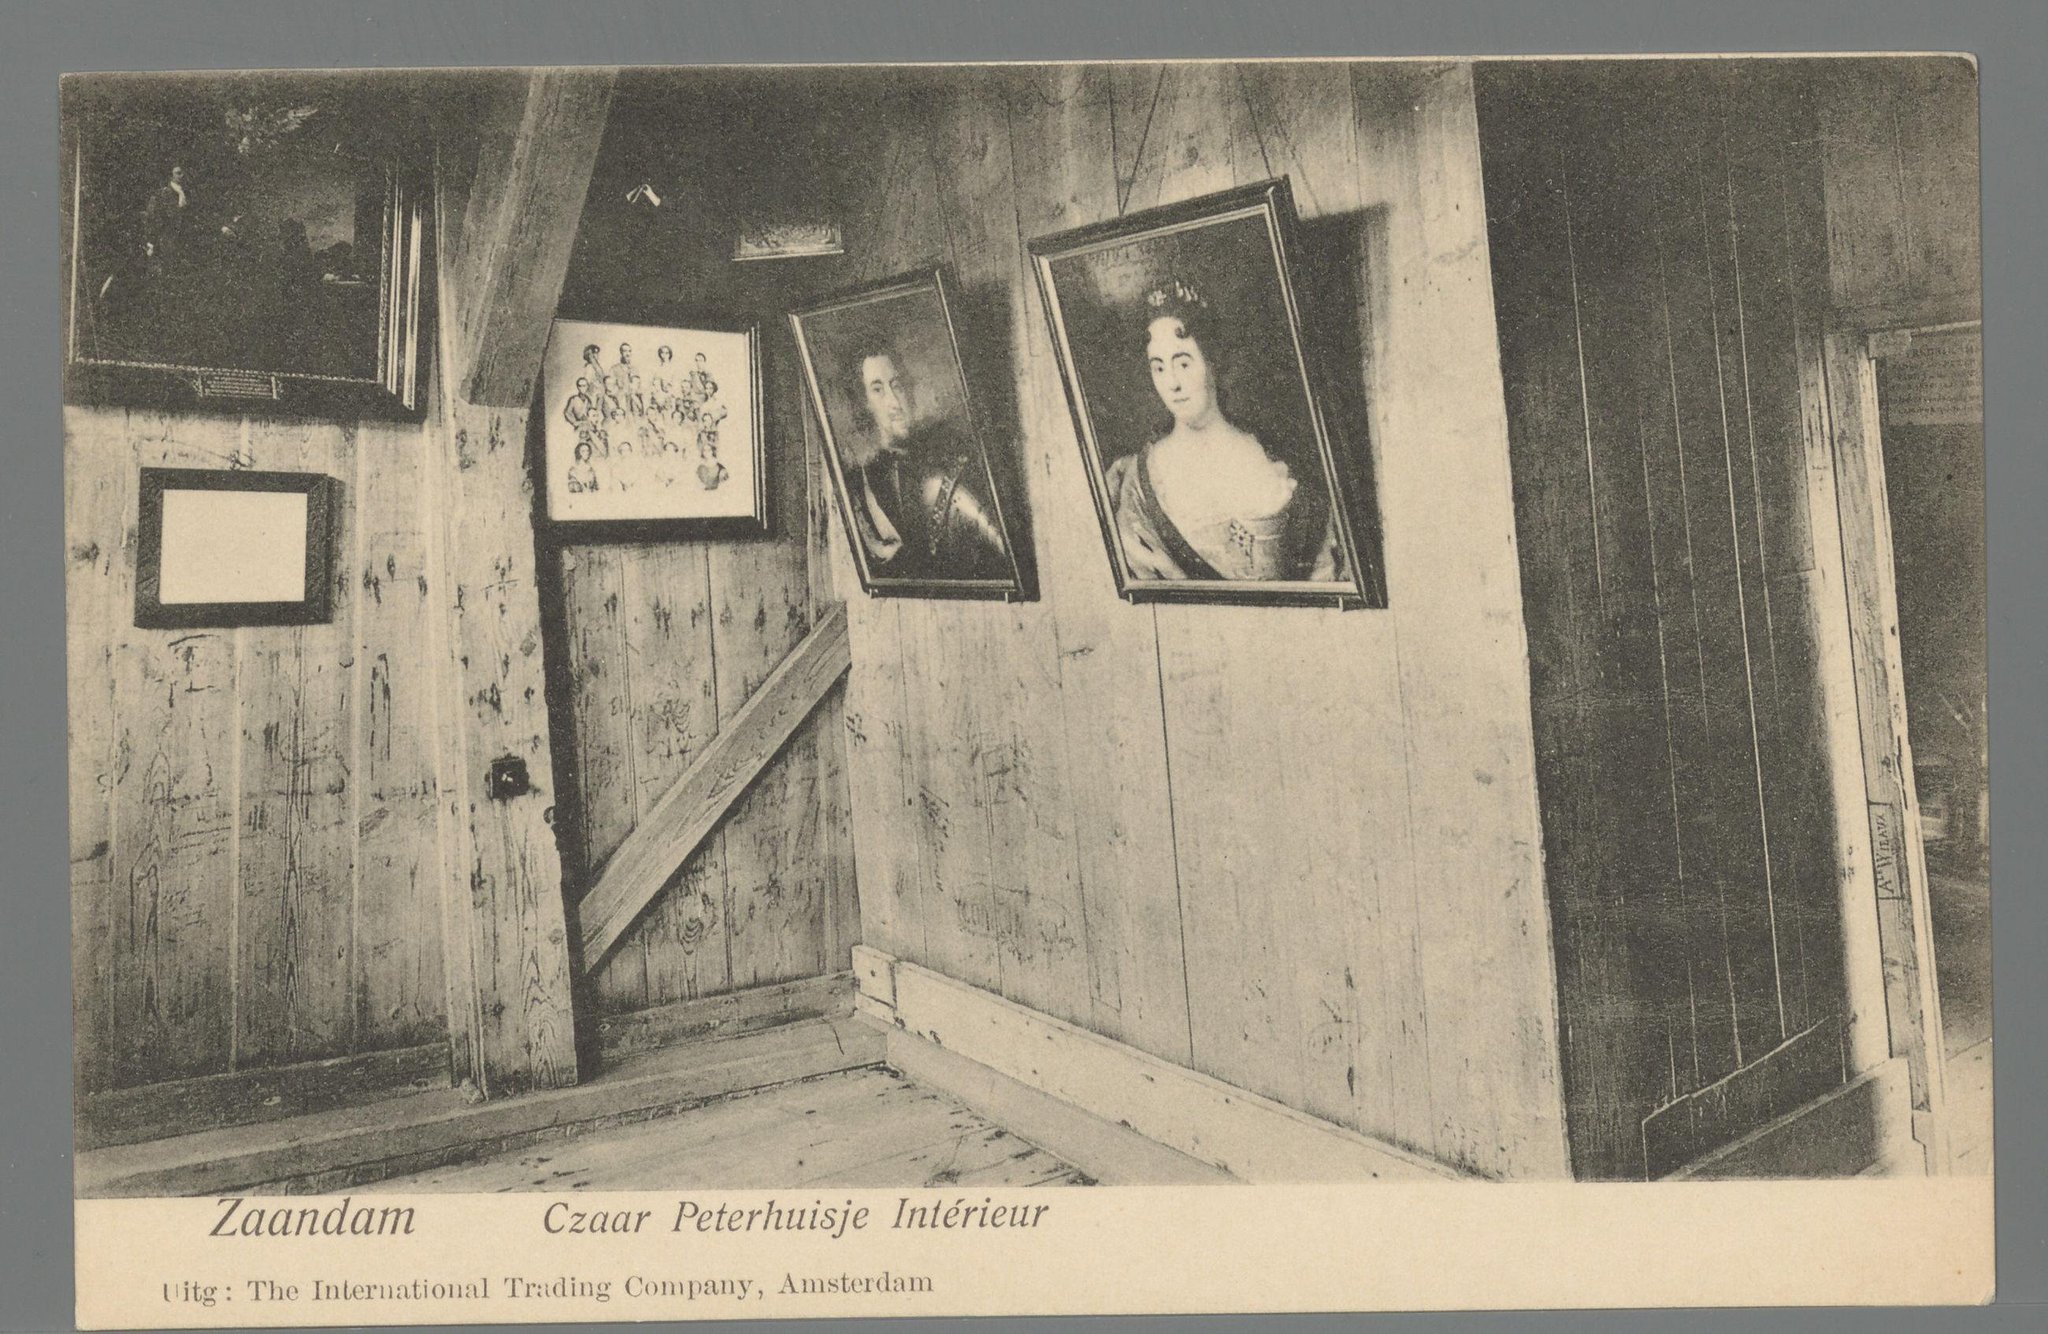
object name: photomechanical print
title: Zaandam. Czaar Peterhuisje Intérieur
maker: Anonymous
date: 1897-1905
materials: cardboard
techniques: photograph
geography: zaandam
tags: painting ~ applied arts, interior of the house, permanent exhibition, museum